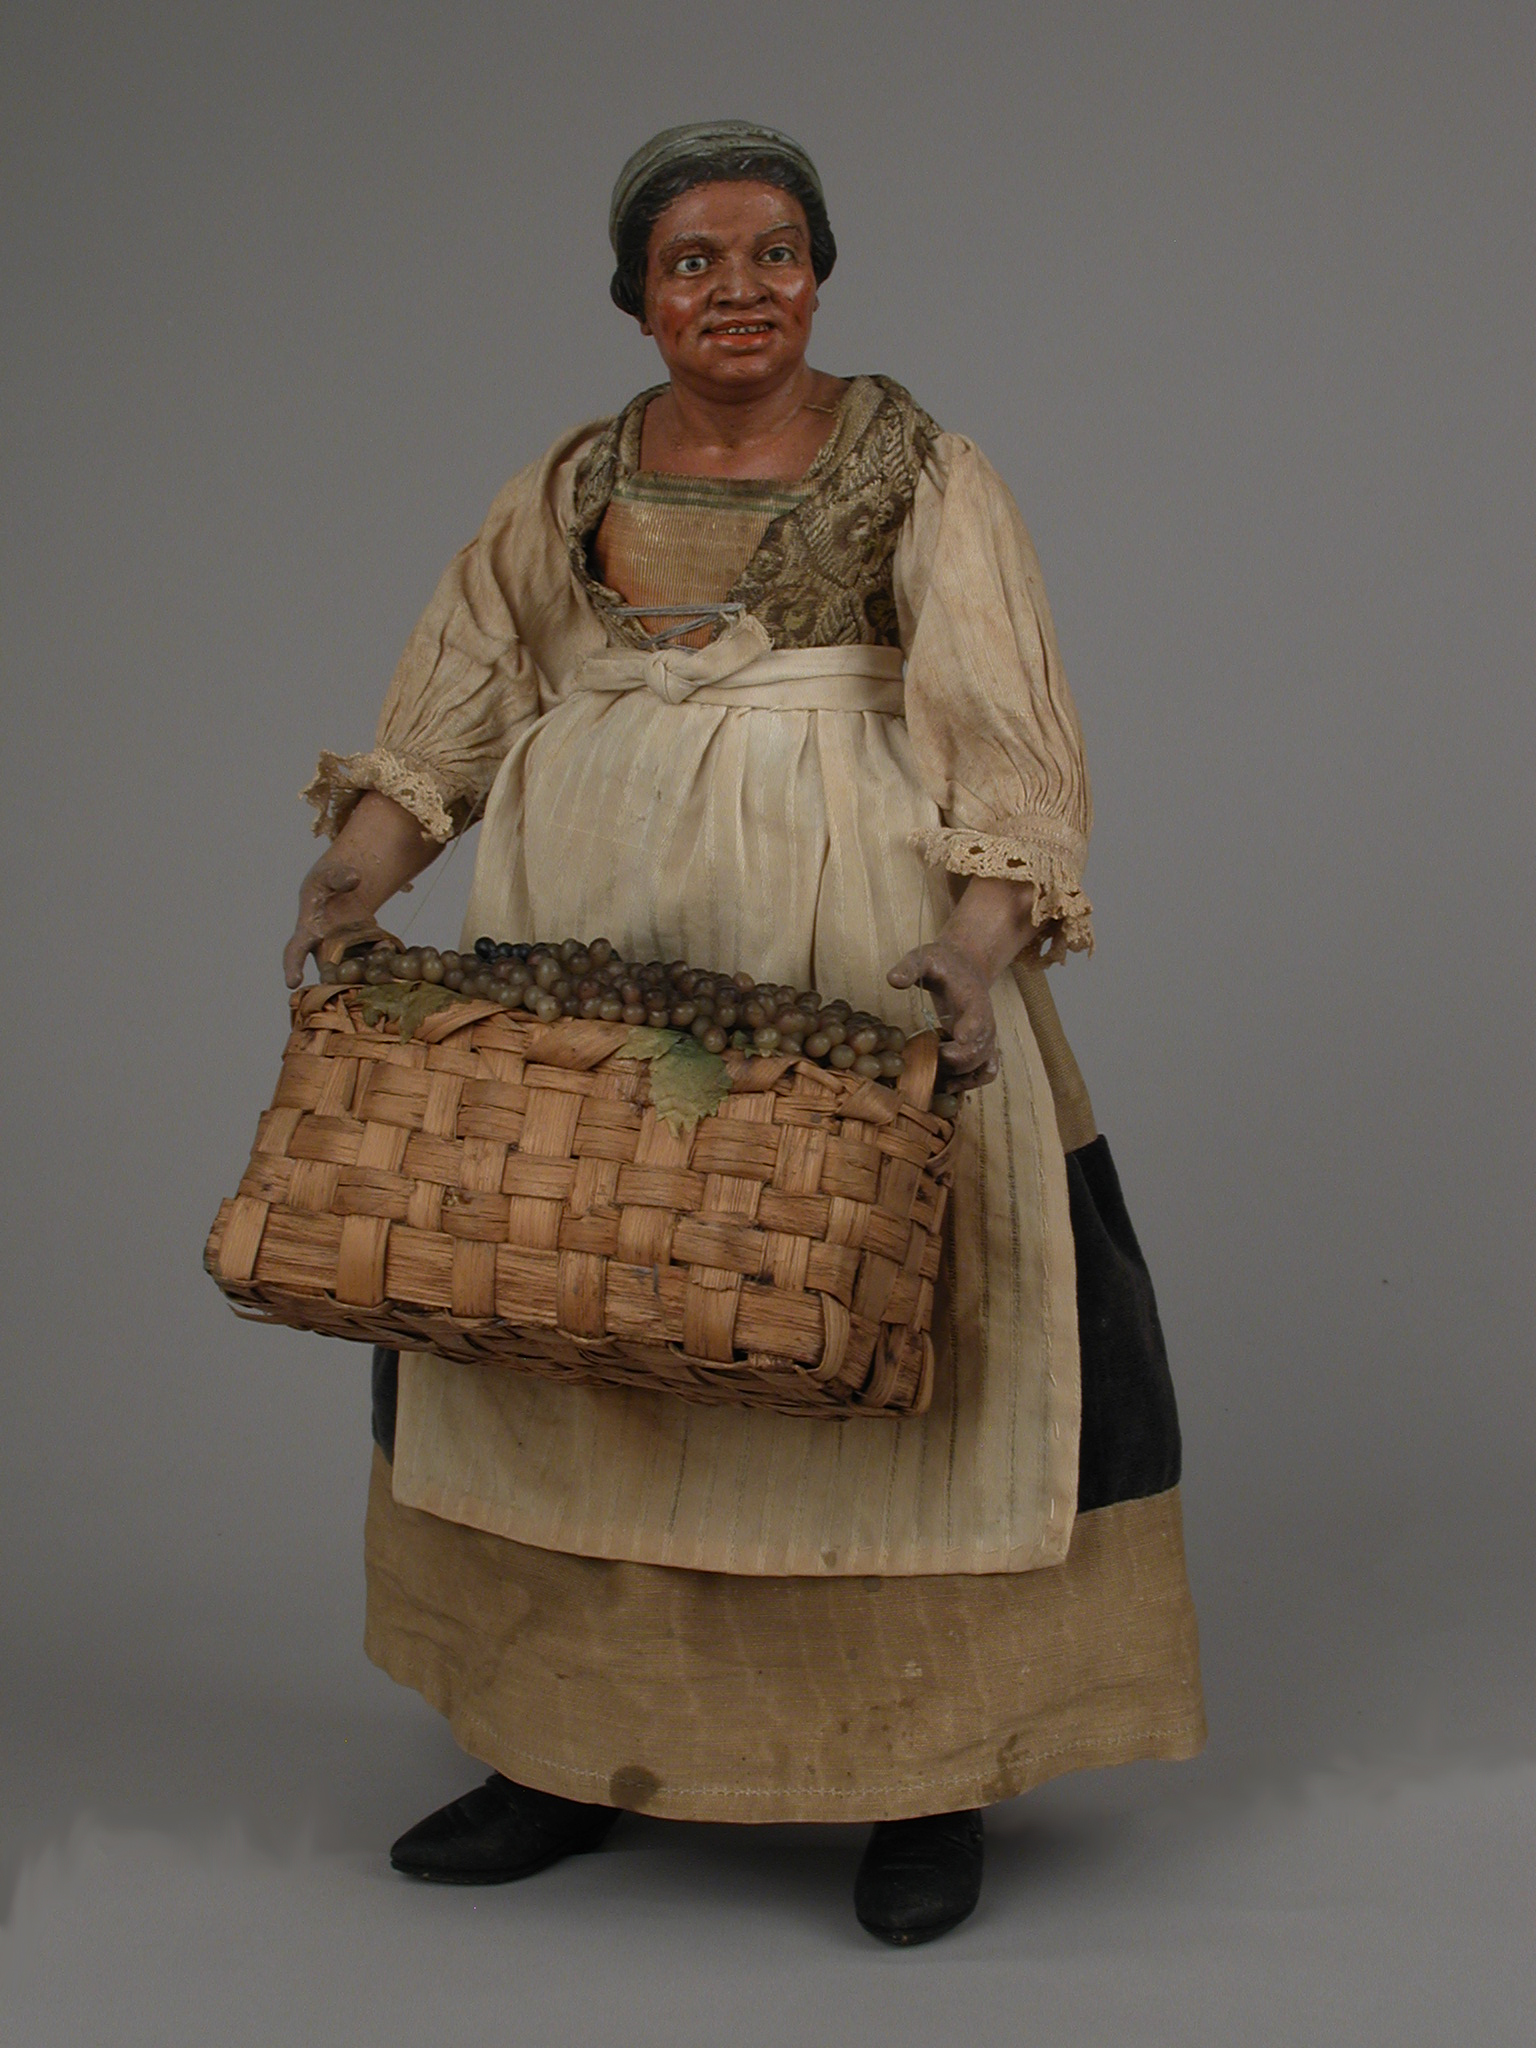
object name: crèche figure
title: Peasant woman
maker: matteo bottigheri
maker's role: maker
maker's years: 1725-1825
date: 1751-1800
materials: cotton, metal, terracotta, fiber, velvet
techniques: polychrome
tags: women,working